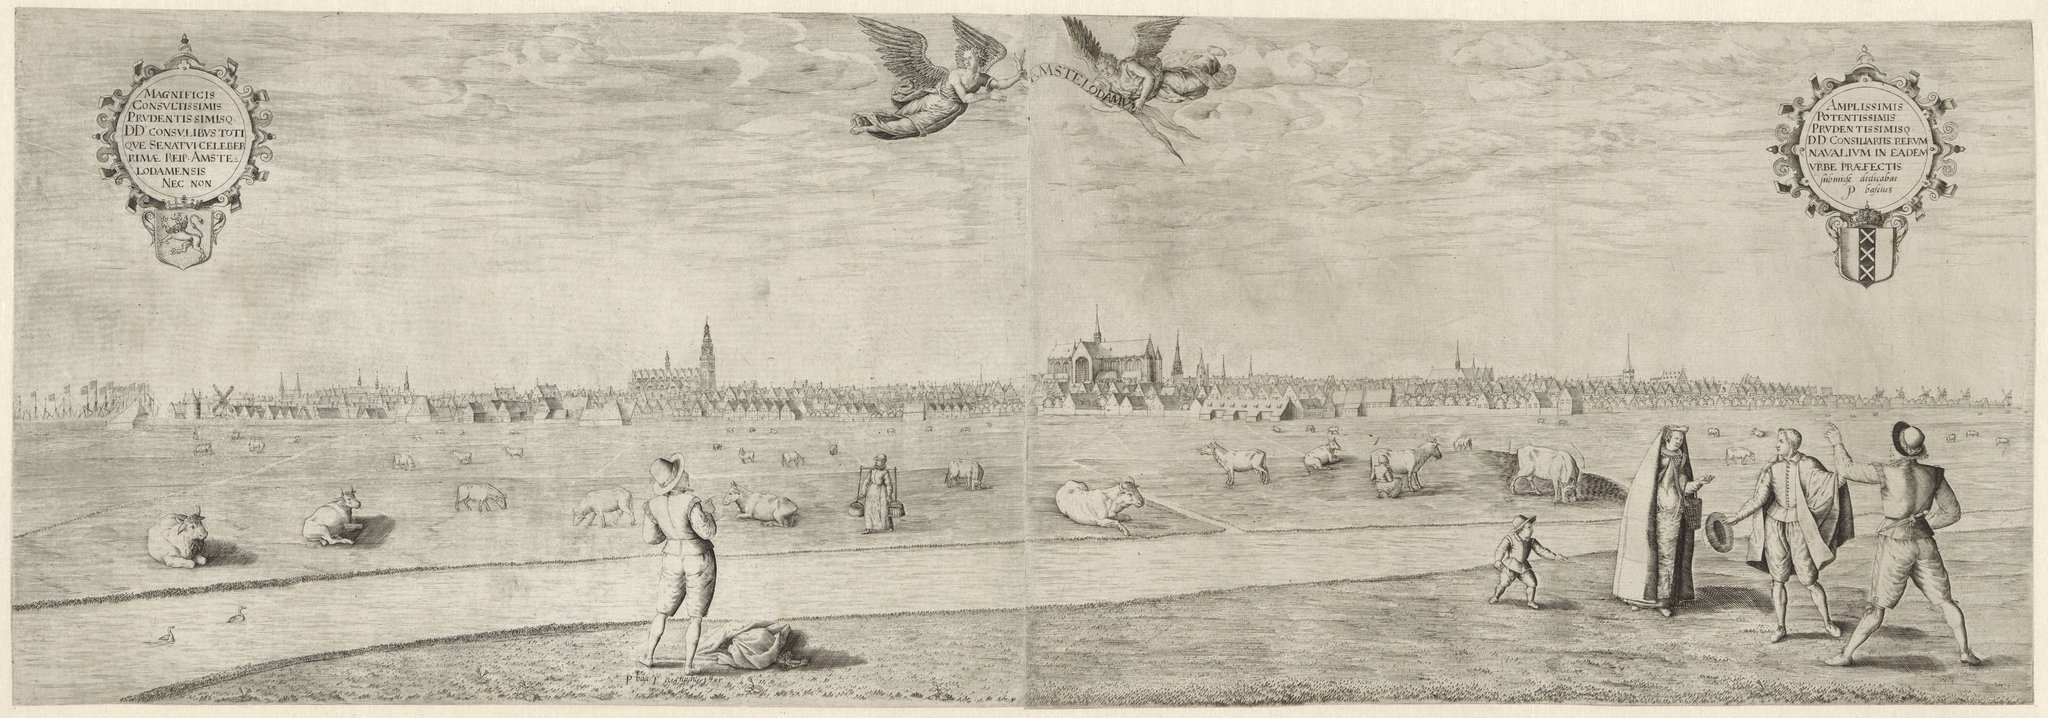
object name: print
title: Gezicht op Amsterdam, gezien vanuit het westen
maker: pieter bast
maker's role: print maker, publisher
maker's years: 1570-1605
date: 1601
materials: paper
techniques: engraving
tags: coat of arms (as symbol of the state, etc.) (+ city; municipal), cow, draughtsman at work, carrying something with yoke, milkmaid, coat of arms (as symbol of the state, etc.) (+ province; provincial), prospect of city, town panorama, silhouette of city, portrait, self-portrait of draughtsman, milking, amsterdam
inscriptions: inscription: ‘pag 11, n 90’, inscription: ‘Meyer 9’, collector's mark: Lugt 2228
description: Gezicht op de stad Amsterdam, genomen uit het Westen. Op het linkerblad staat op den voorgrond: Bast de stad af te teekenen. Naast hem op den grond ligt zijn mantel en degen. Meer verwijderd in een weiland waarin verscheidene koeien, loopt eene boerin, met het melkjuk op de schouders. Onder de teekenaar op den grond: P. bast. F. et excudi. 1601. Op het rechterblad ziet men op den voorgrond twee heeren, die met een dame staan te praten, terwijl een knaapje naar hen toekomt loopen. Meer verwijderd, eene weide, met koebeesten, van welke één door een boerin gemolken wordt. In 't midden in de lucht (gedeeltelijk op het linker- gedeeltelijk op het rechterblad) twee engelen, die een lambel houden, waarop: Amstelodamvm. In den l.b: van het linker- en in den r.b: van het rechterblad een cartouche met de opdracht van den graveur aan den Amsterdamschen magistraat en de admiraliteit. Onder de cartouchen, de wapens van Amsterdam en van Holland.